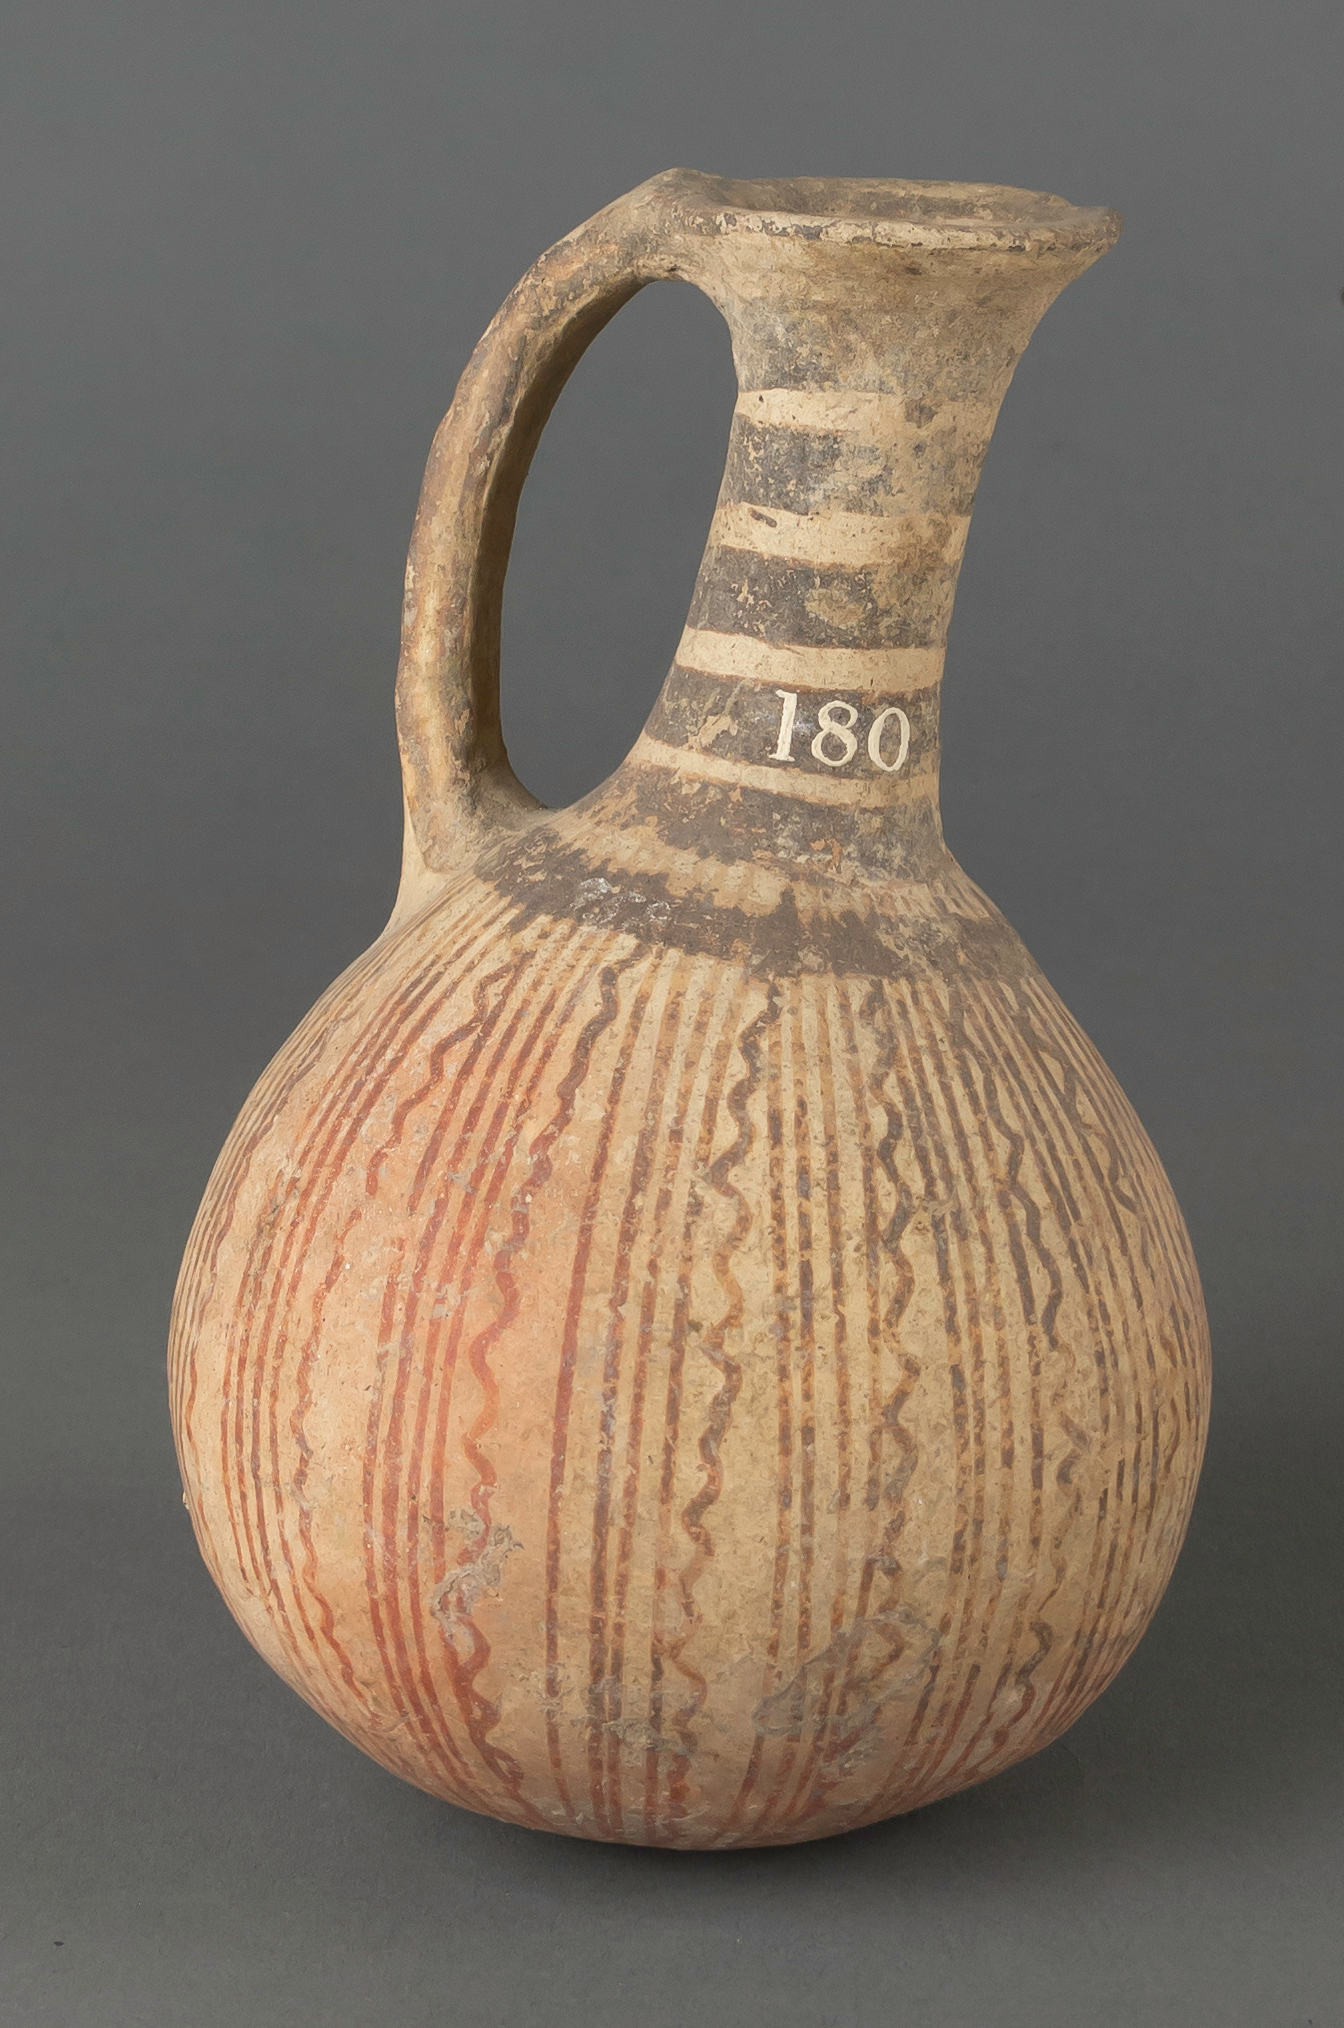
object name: jug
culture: cypriot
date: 2000-1600 BCE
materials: terracotta